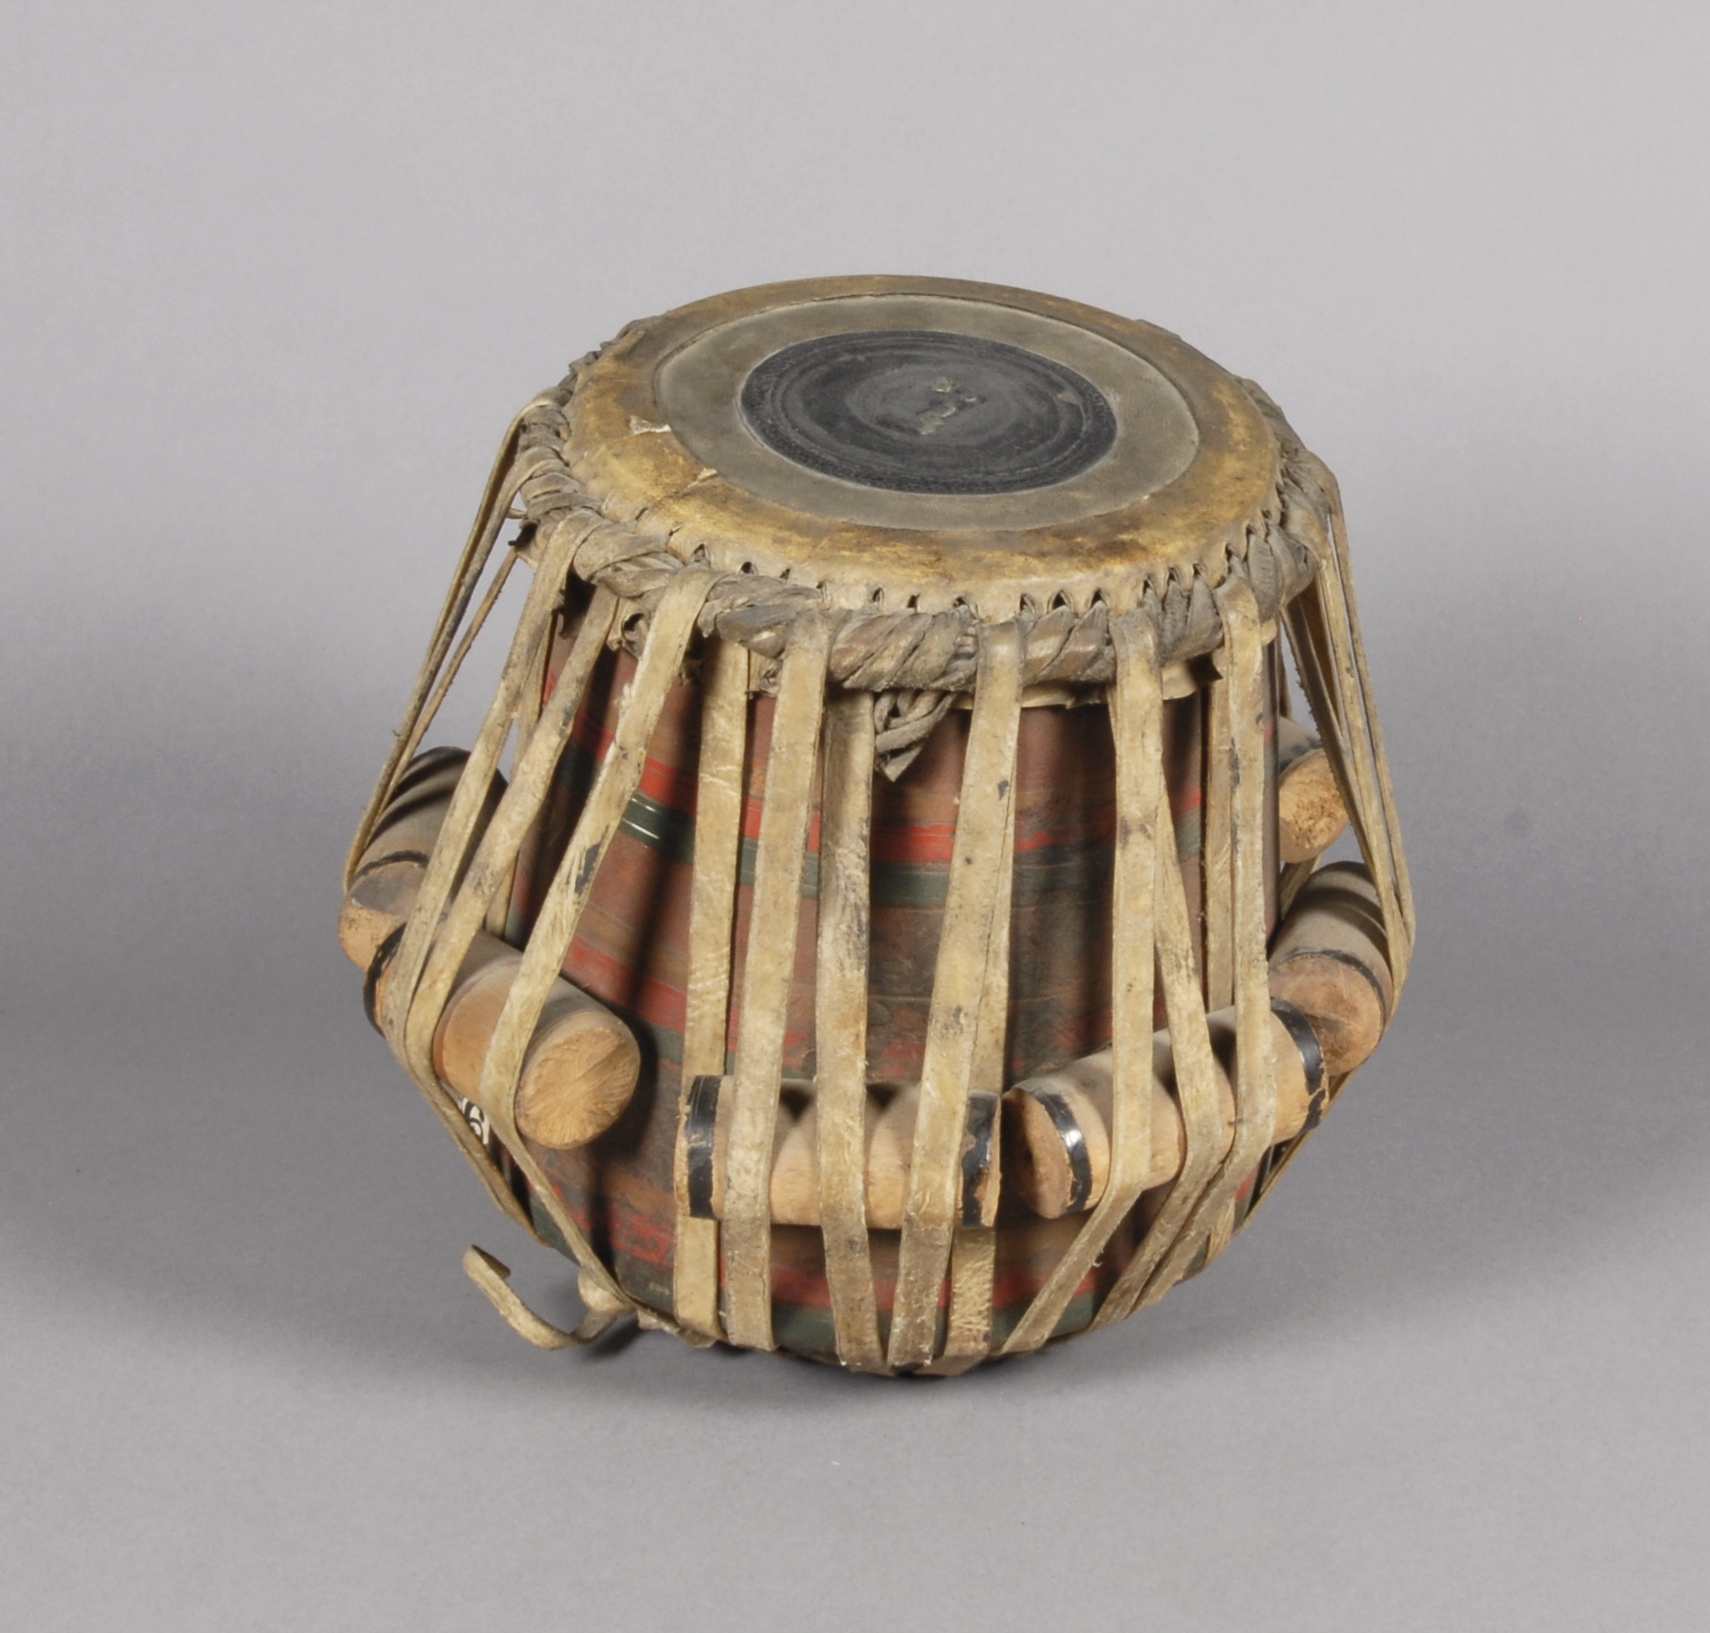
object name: tablā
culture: indian, north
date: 1867-1900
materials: skin, wood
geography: india